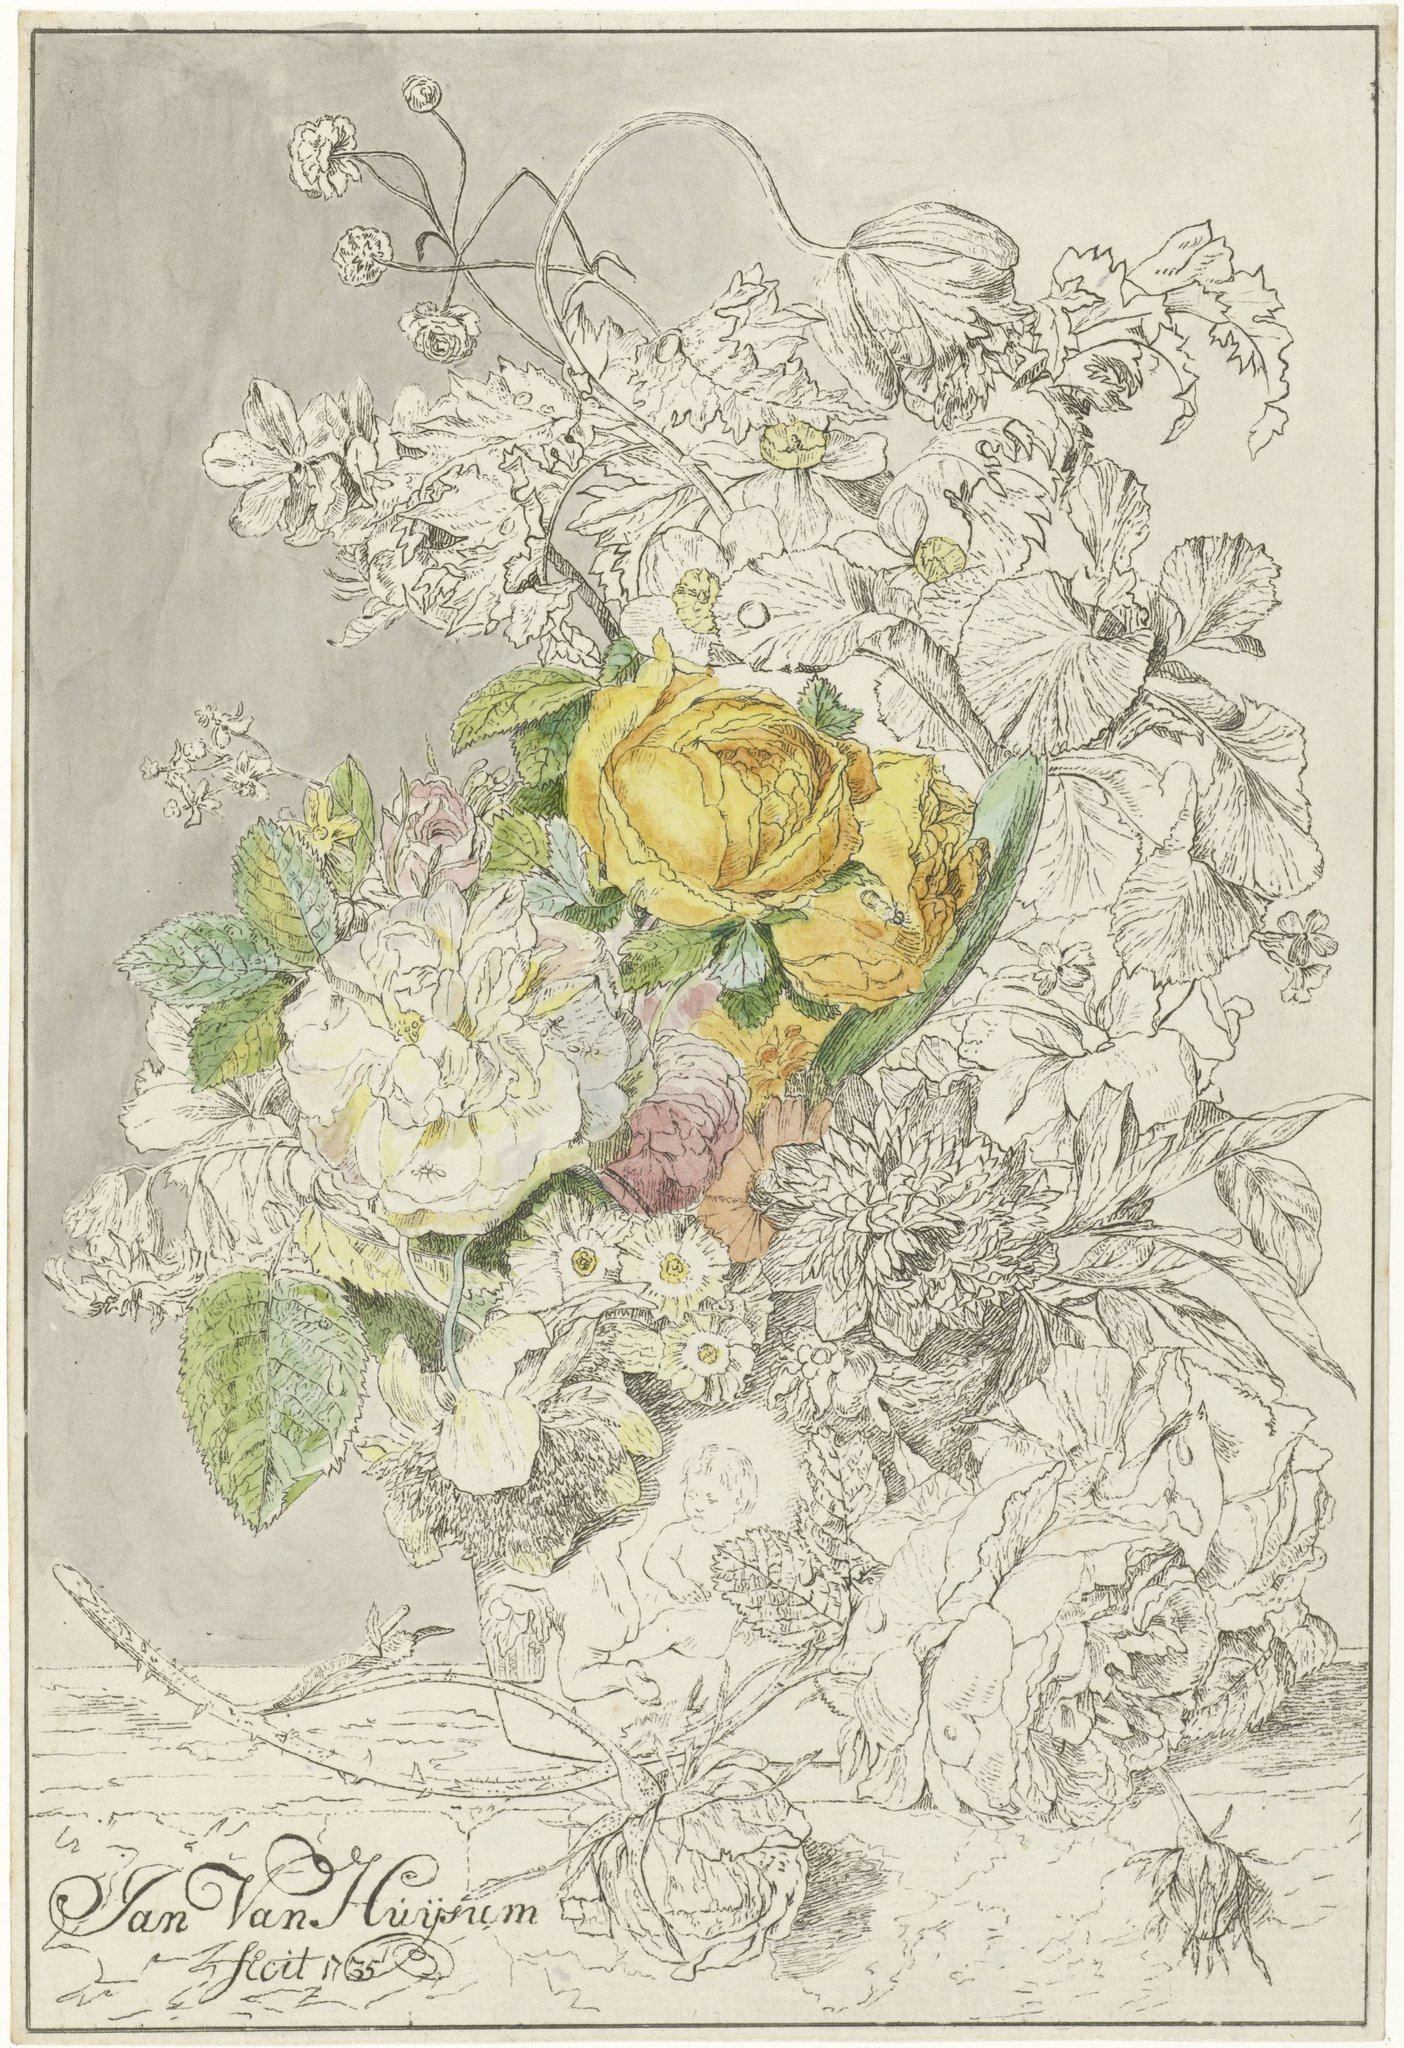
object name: print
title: Bloemstuk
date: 1778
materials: paper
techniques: etching, hand coloring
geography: amsterdam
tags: flowers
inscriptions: inscription: ‘Klad proef Geoffreerd 1778 aan mijne waarde vriend Martinet // Ploos v Amstel JC fecit 1778 in aqua forti’, collector's mark: Lugt 2228